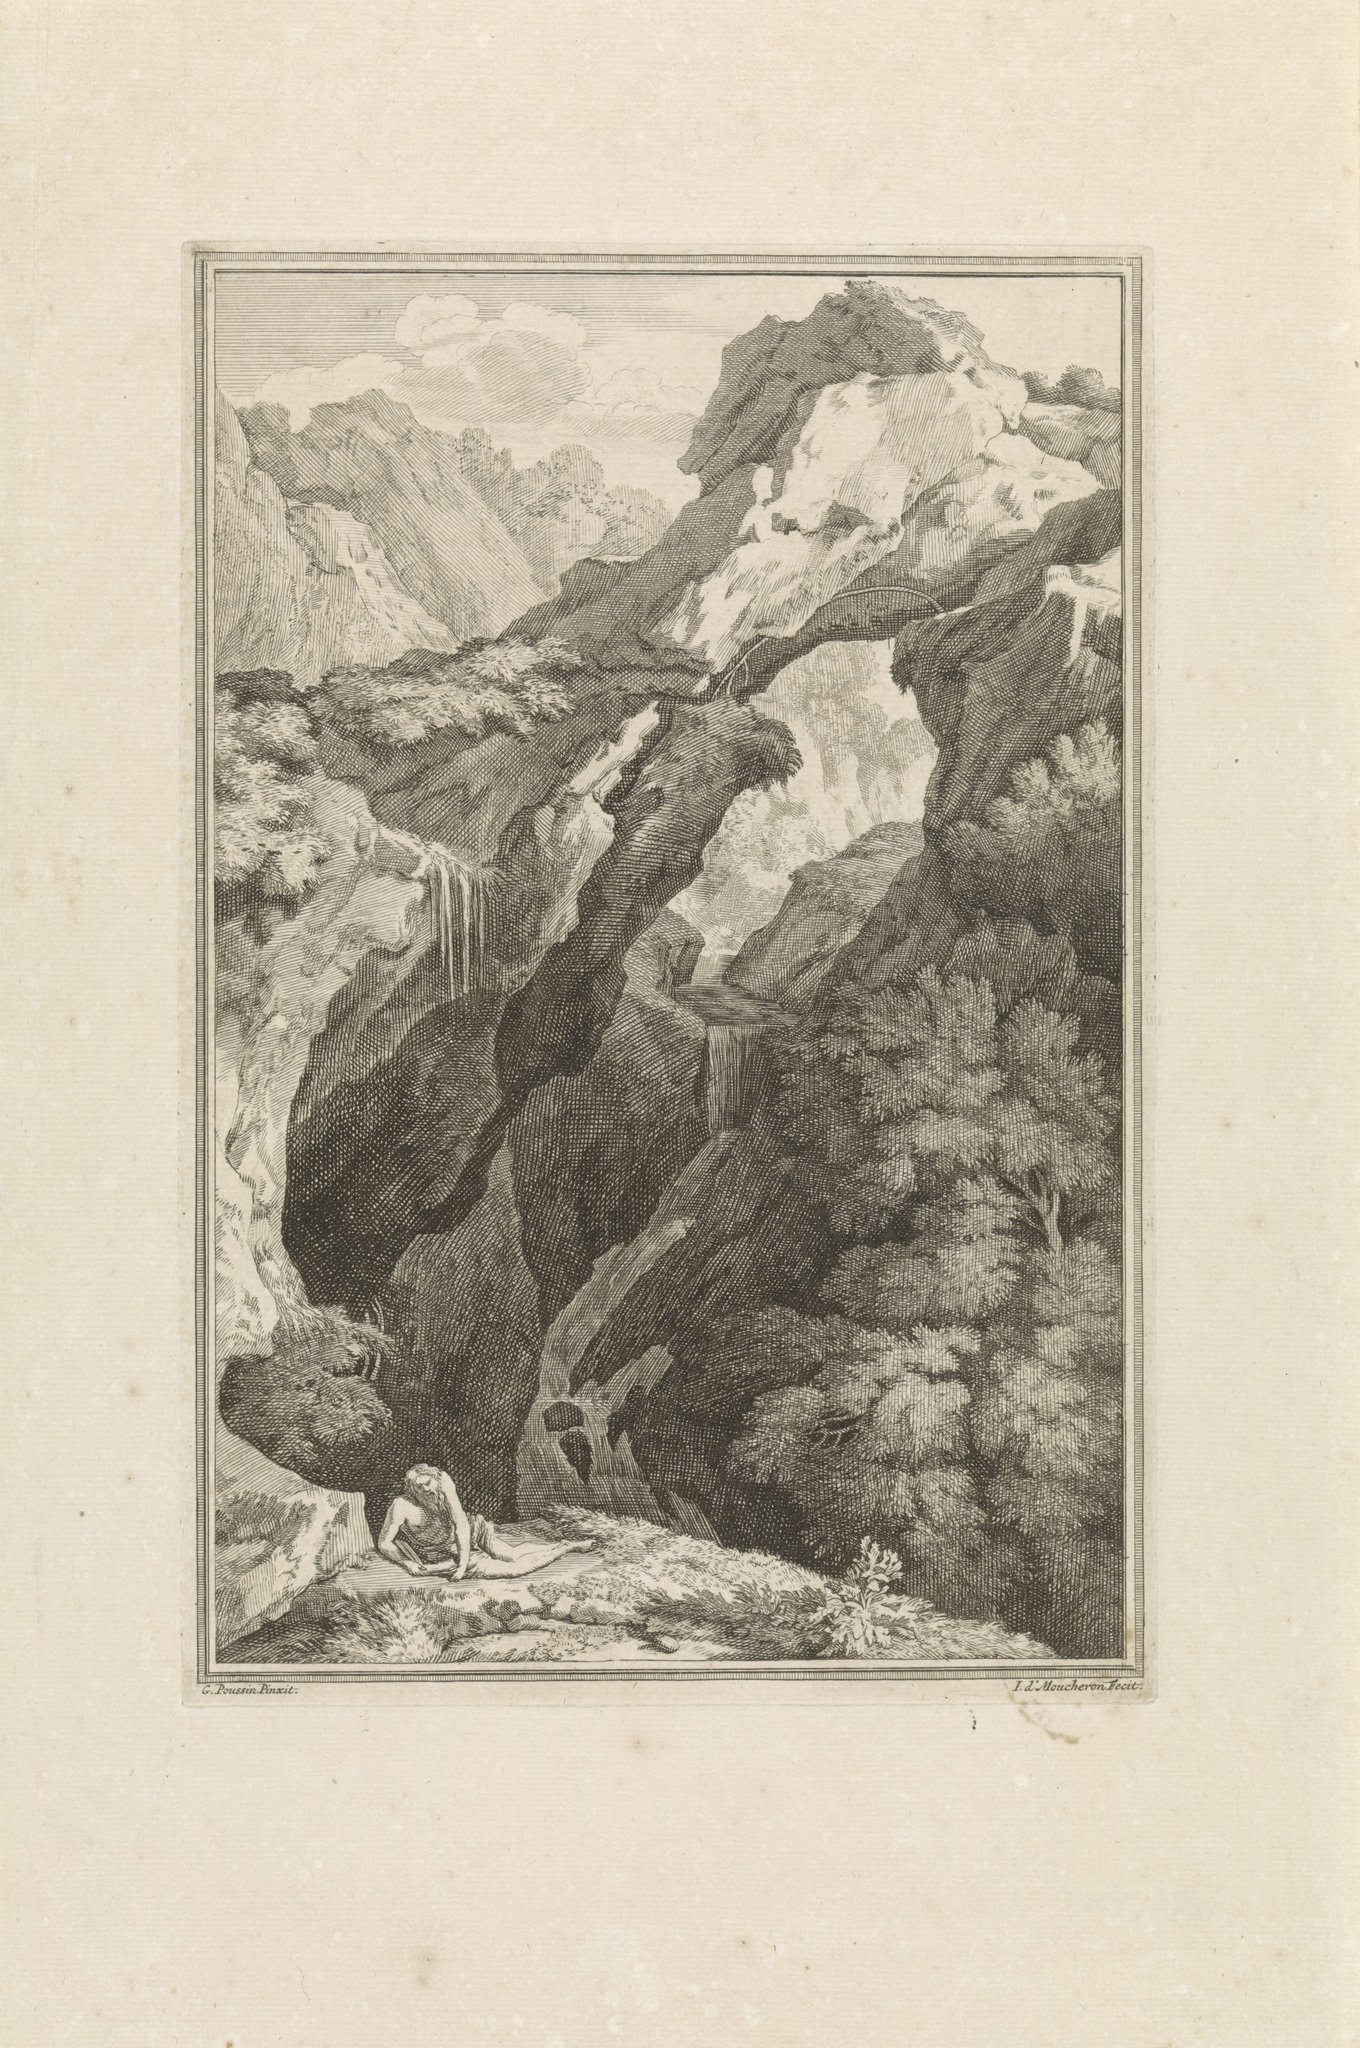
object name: print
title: Berglandschap met waterval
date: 1697-1744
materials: paper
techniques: engraving, etching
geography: amsterdam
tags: waterfall, anchorite, hermit, pastorals, arcadian scenes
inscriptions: collector's mark: Lugt 240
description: Onderaan rotsen en bergen met een waterval zit een kluizenaar te lezen in een boek.